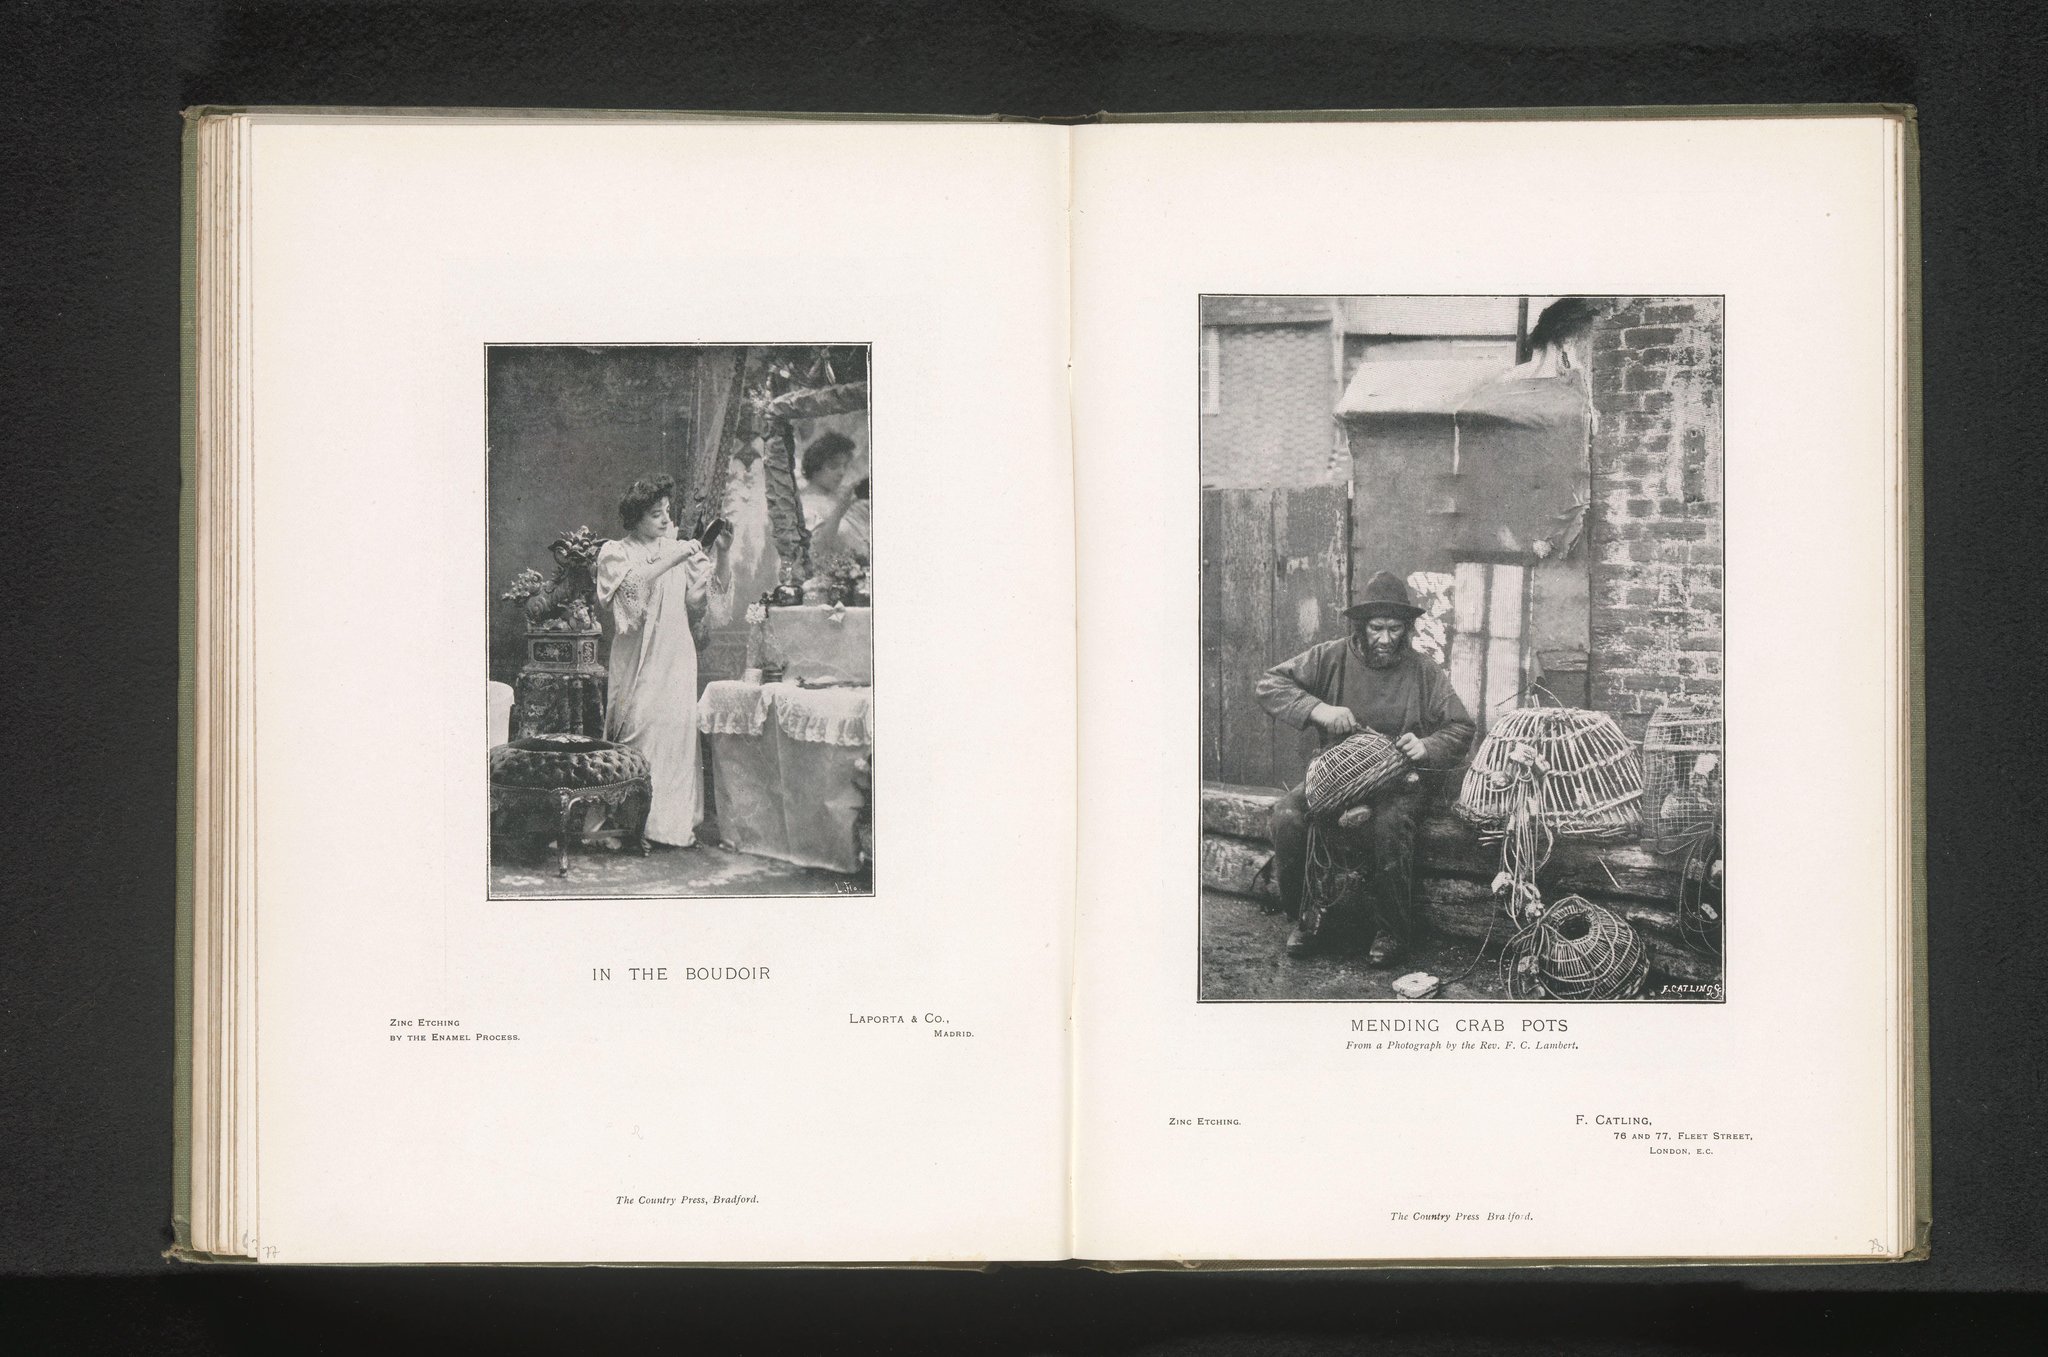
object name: page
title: Visser repareert krabbenfuik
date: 1893-1898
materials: paper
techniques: autotype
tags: mending of fishing nets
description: Prent op zevende ongenummerde pagina na pagina 92.